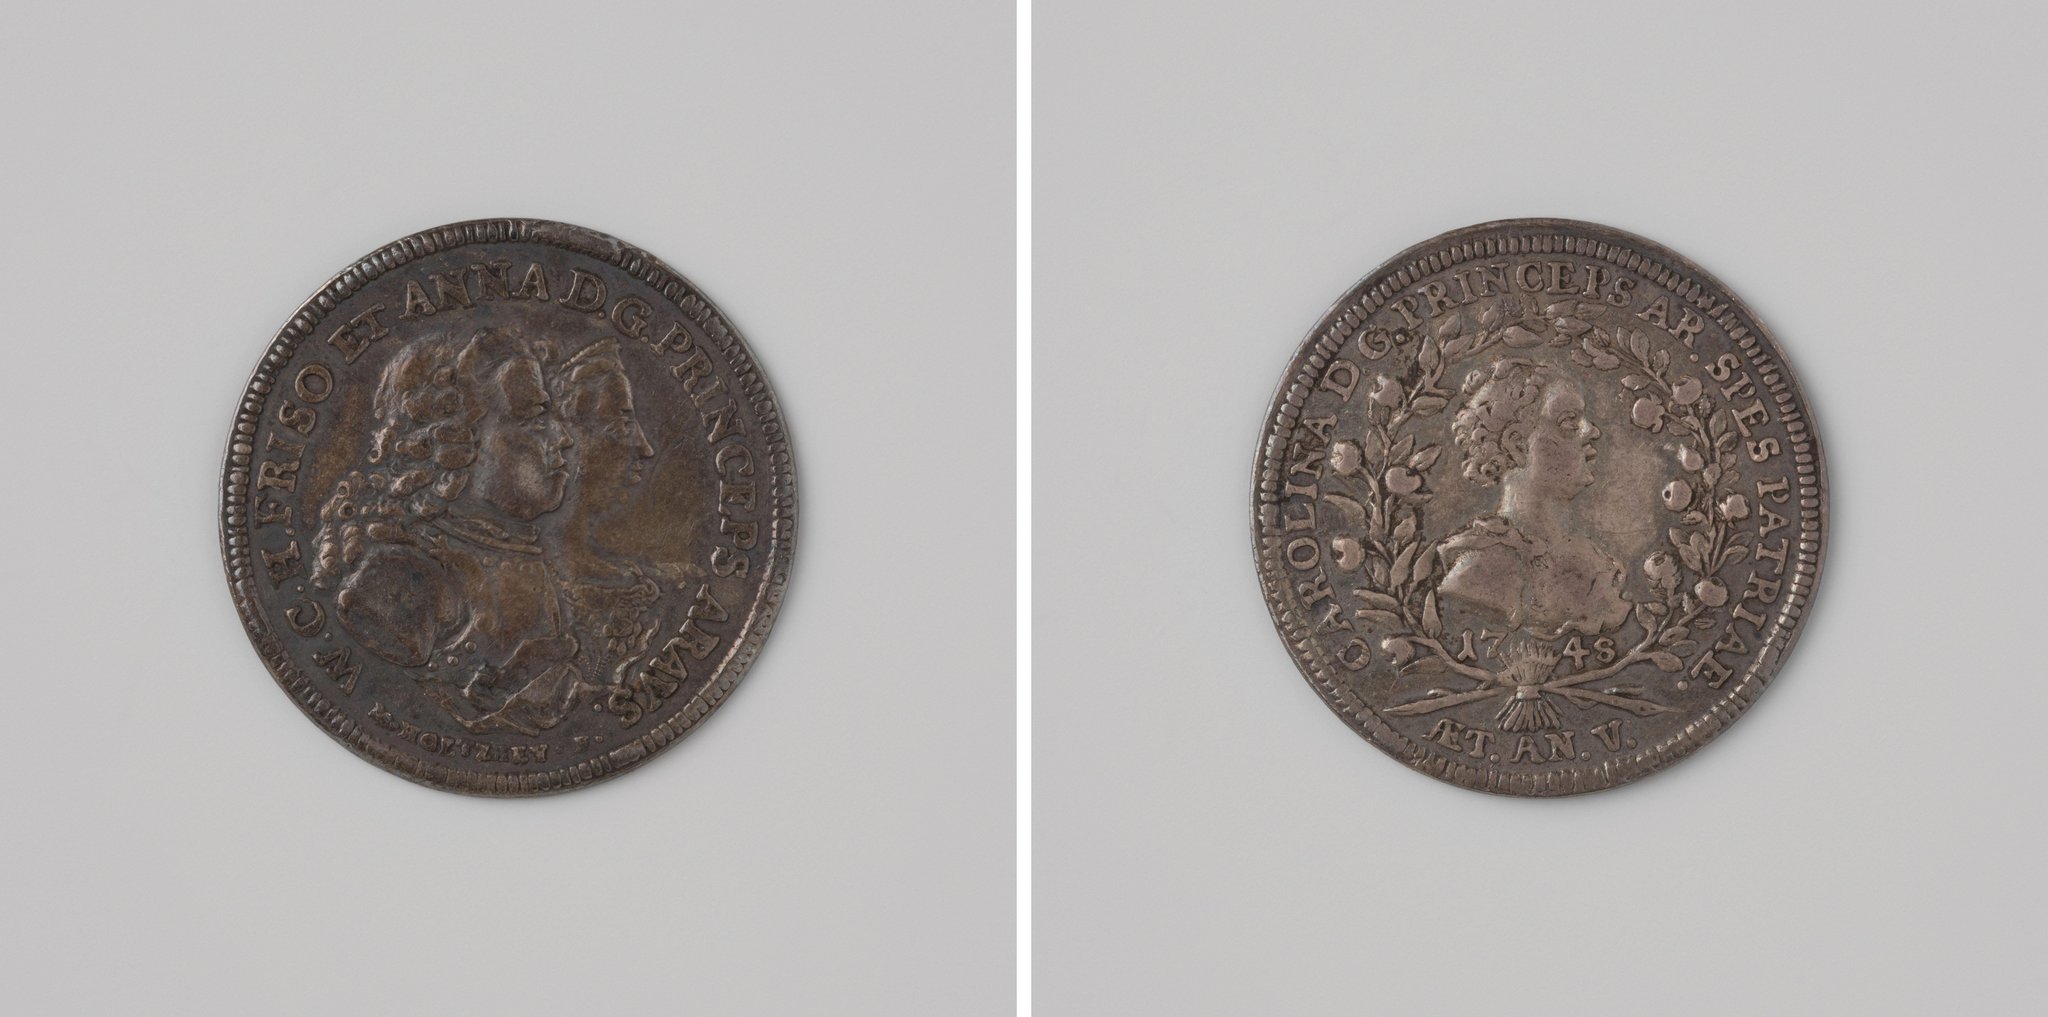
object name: history medal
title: Vijfde verjaardag van prinses Carolina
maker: martinus holtzhey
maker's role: medailleur, muntmaker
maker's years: 1697-1764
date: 1748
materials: silver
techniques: striking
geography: amsterdam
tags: carolina (prinses van oranje-nassau), willem iv (prins van oranje-nassau), the hague, anna van hannover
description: Zilveren penning. Voorzijde: borststuk man en vrouw met diadeem binnen omschrift. Keerzijde: borststuk jong meisje boven jaartal binnen krans van oranjetak en rozetak, met lint gebonden aan pijlenbundel boven opschrift, binnen omschrift